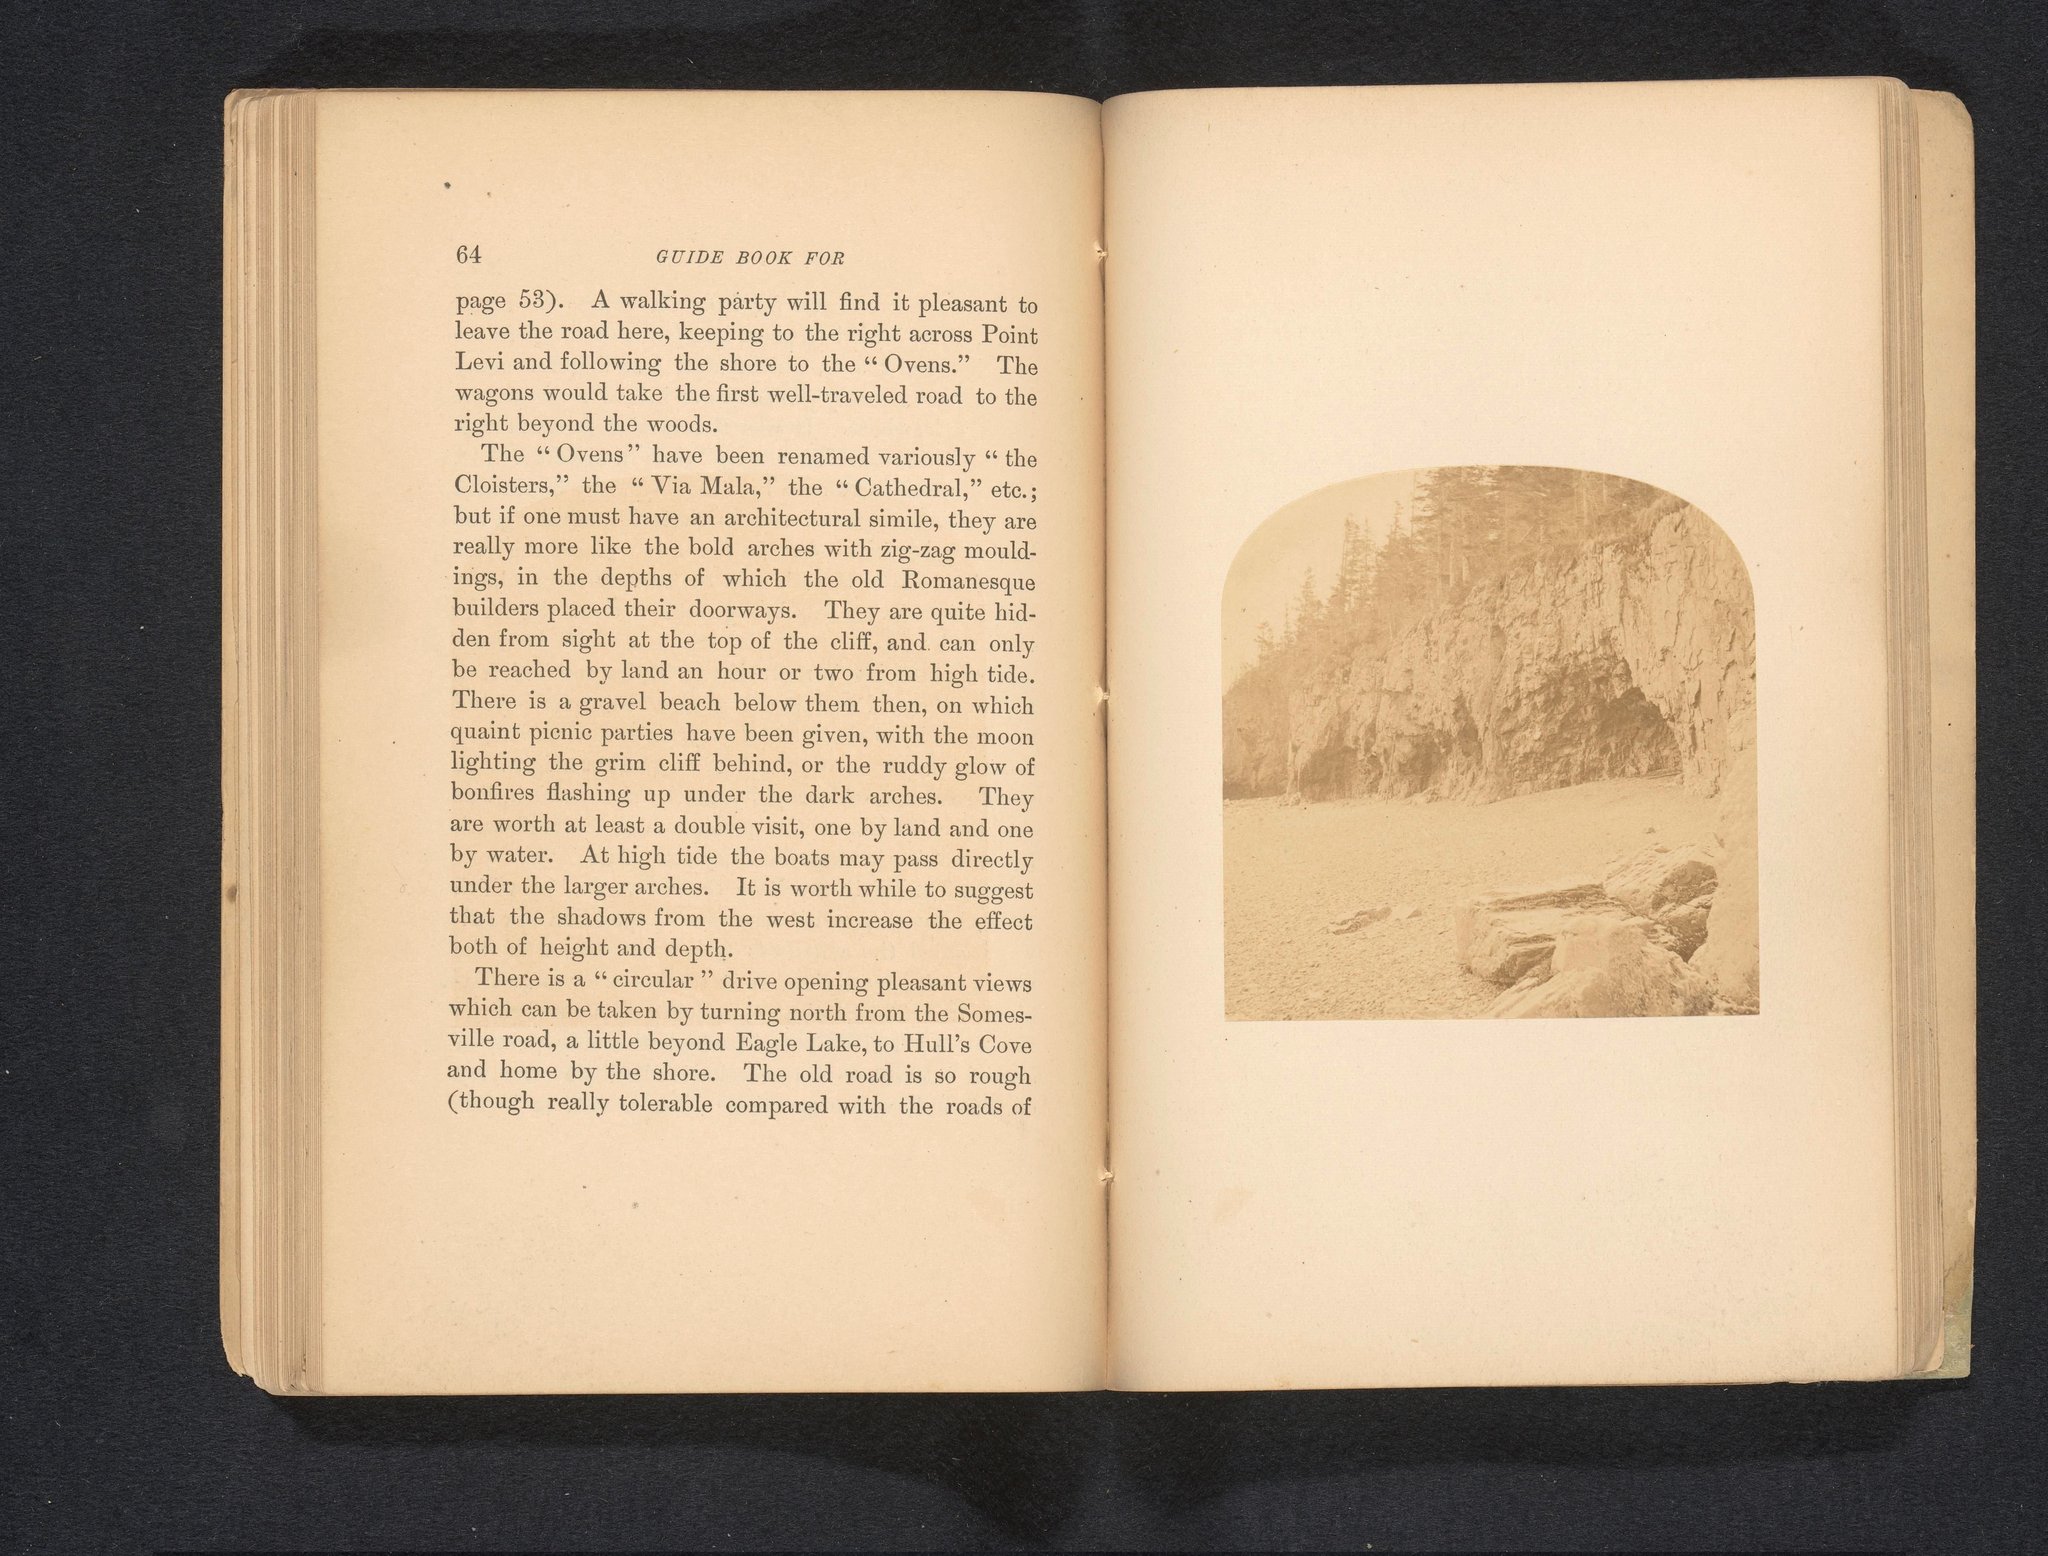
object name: photograph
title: Gezicht op rotsformaties aan het strand te Mount Desert Island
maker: Anonymous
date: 1877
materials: photographic support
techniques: albumen print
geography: mount desert island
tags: rock-formations, beach